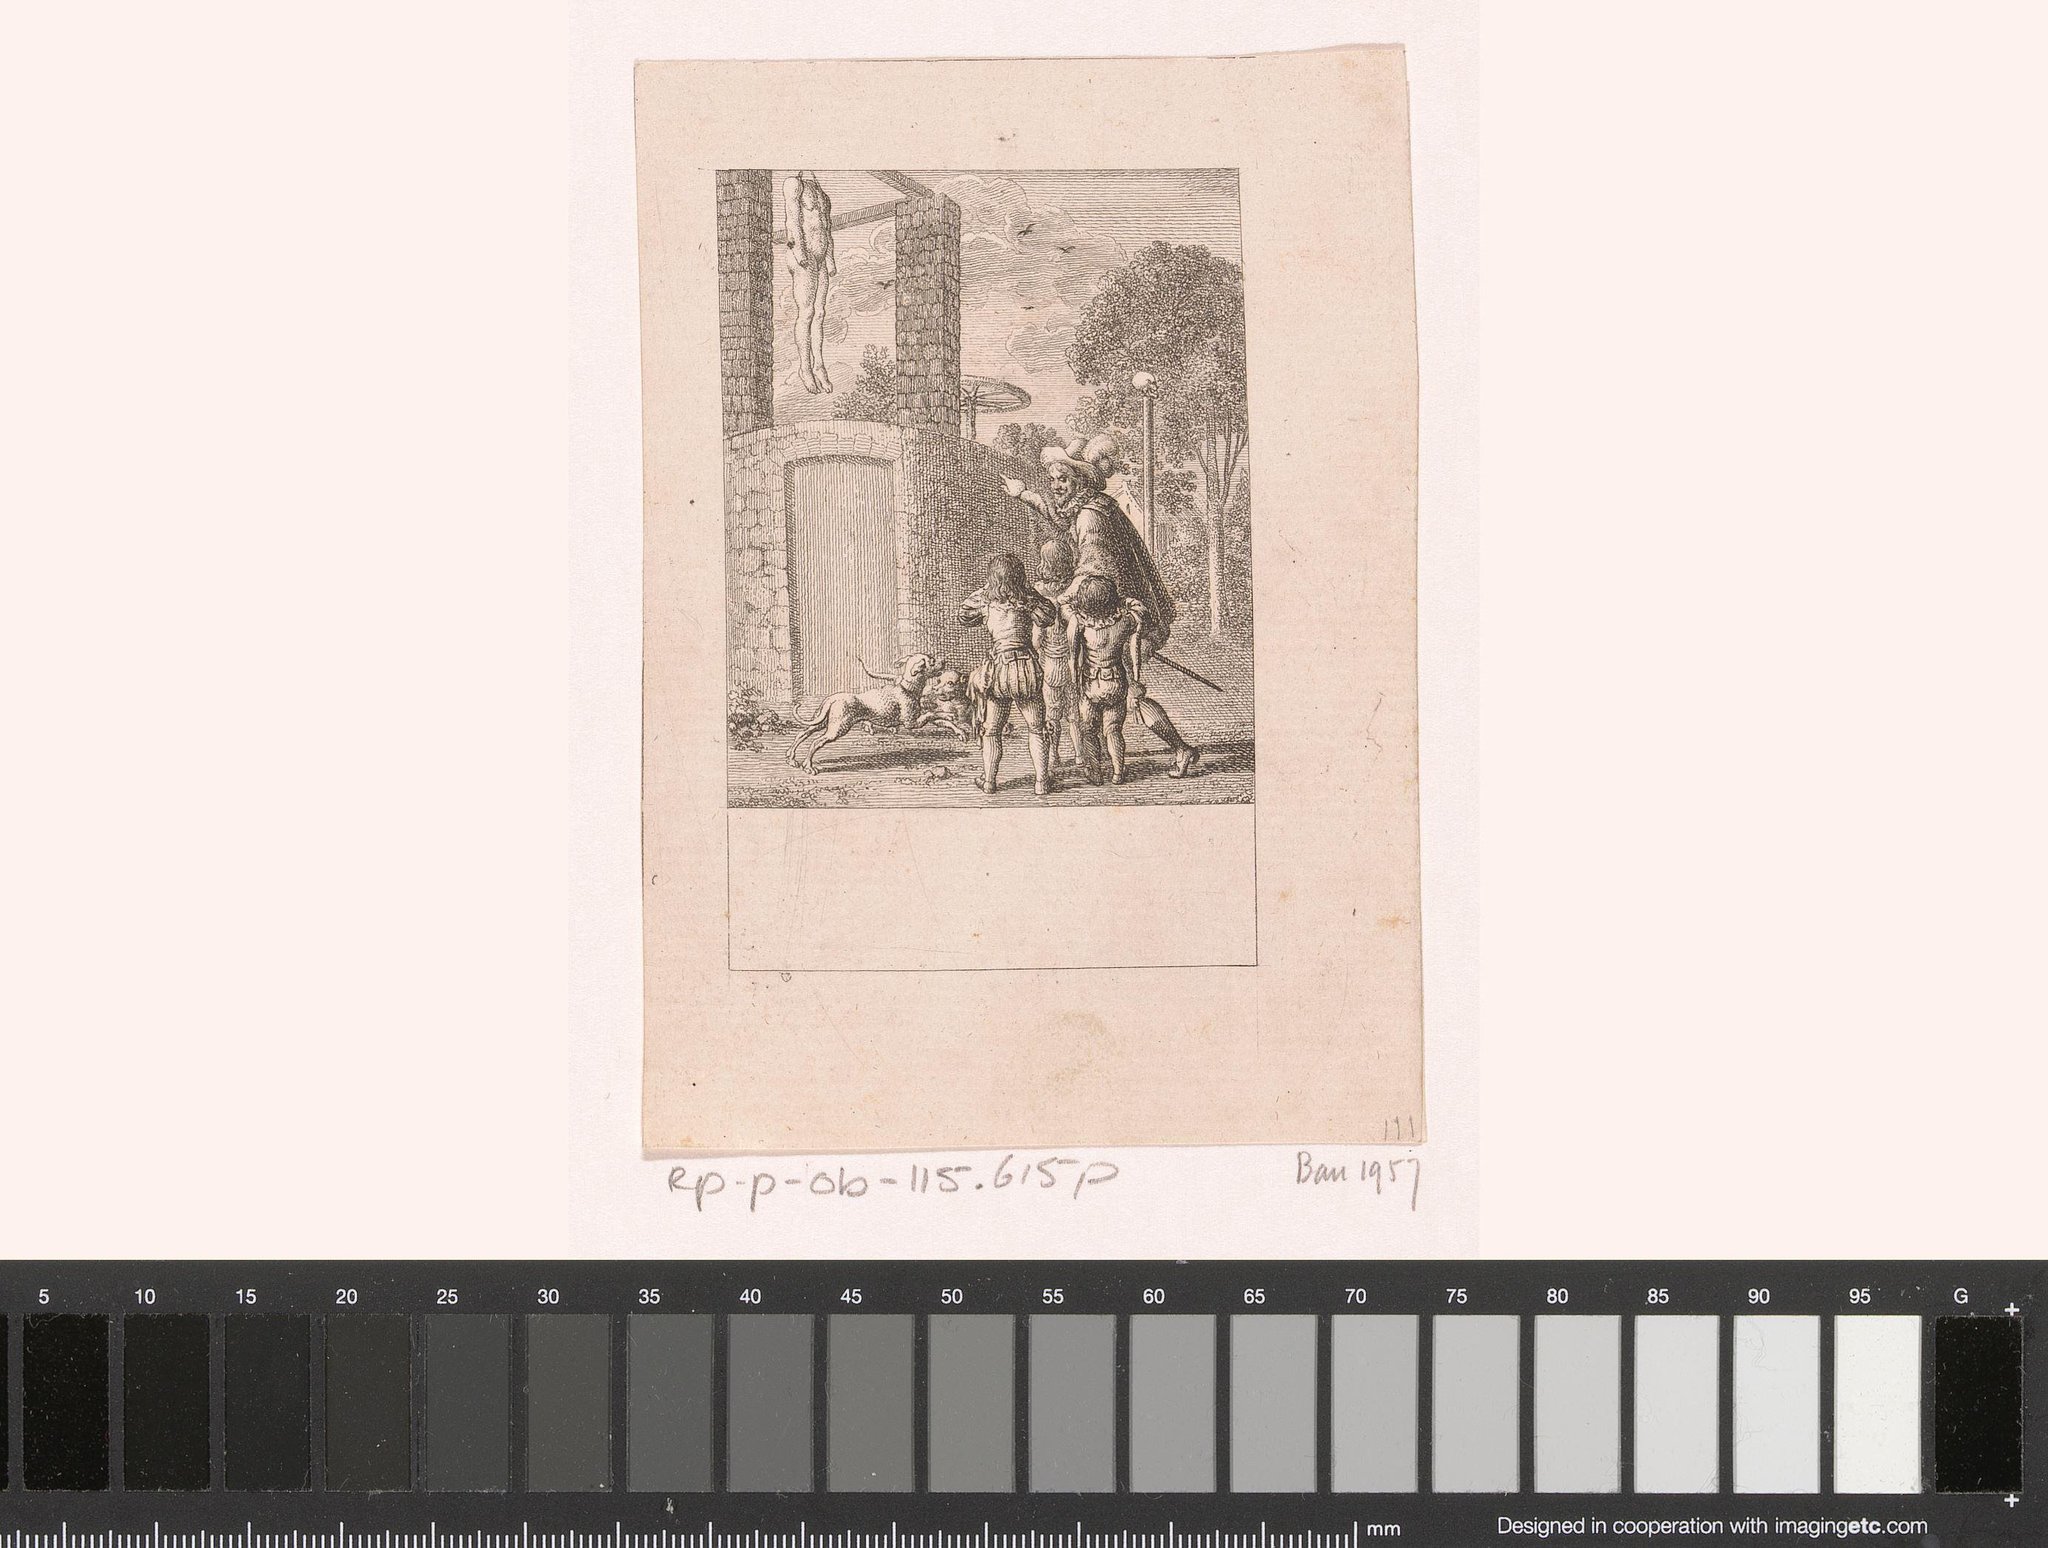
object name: print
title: Coligny's onthoofde lichaam wordt door zijn kinderen aanschouwd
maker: daniel nikolaus chodowiecki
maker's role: draughtsman, print maker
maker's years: 1726-1801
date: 1799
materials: paper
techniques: etching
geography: berlin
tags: paris, politician, gaspard de coligny (ii), headless body of a beheaded person, hanging figure (by the arms, legs, etc.)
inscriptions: collector's mark: Lugt 2228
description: Prent gebruikt voor: Historisch-genealogischer Kalender auf das Jahr 1799 und 1800. Die Geschichte der Bartholomäusnacht oder die Bluthochzeit zu Paris. Berlijn: Johann Friedrich Unger, [1799].